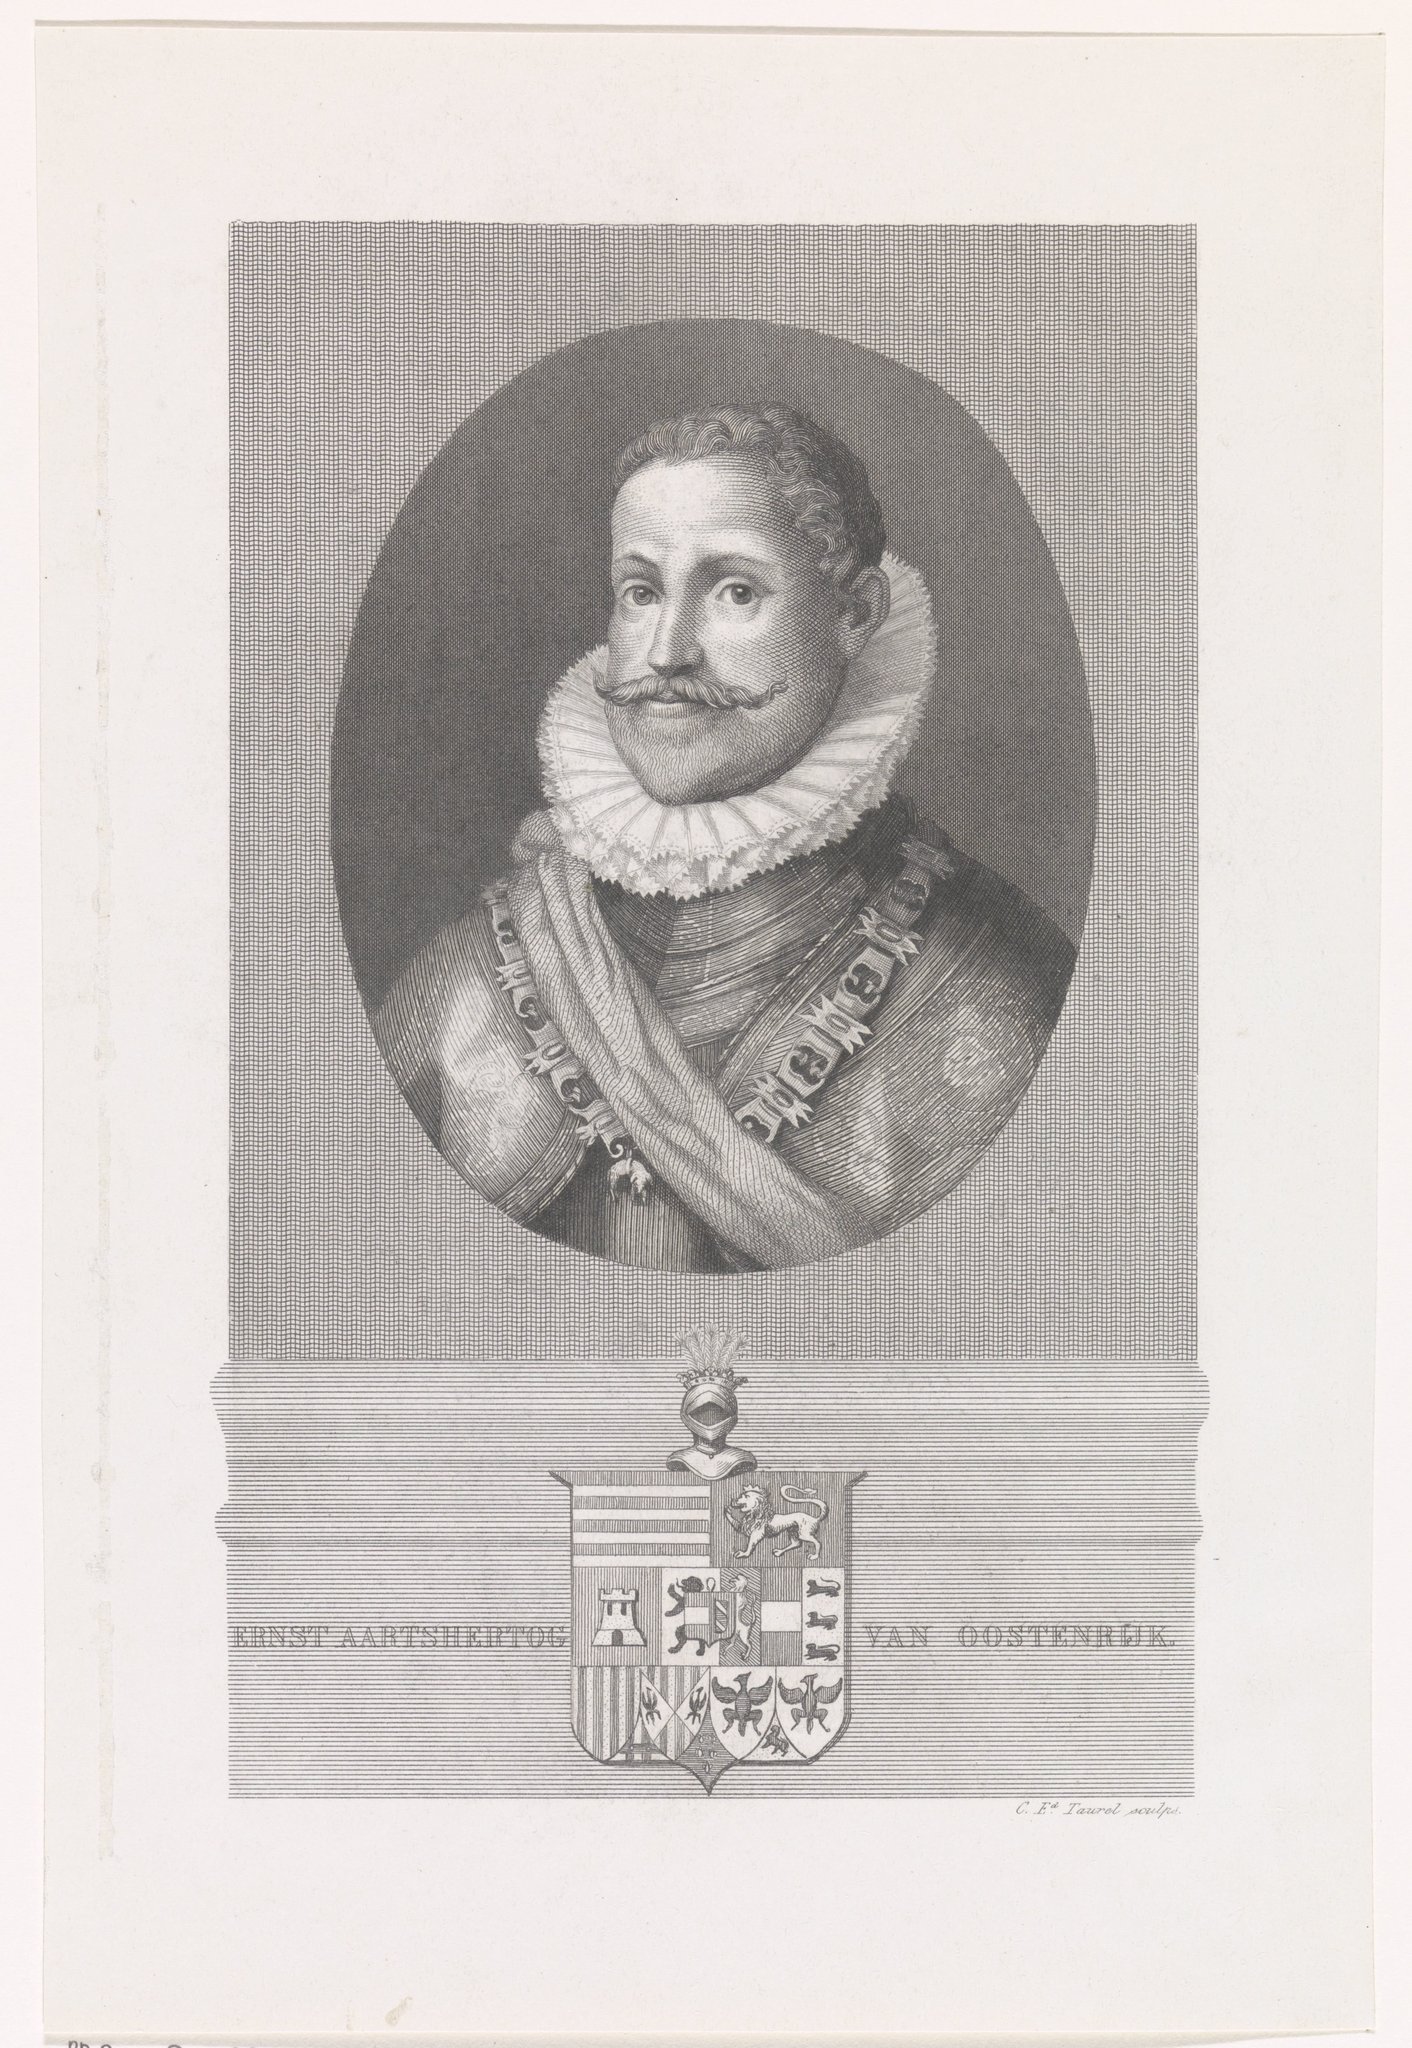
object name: print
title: Portret van Ernst, aartshertog van Oostenrijk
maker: edouard taurel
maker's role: draughtsman, print maker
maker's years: 1824-1892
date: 1841-1879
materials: paper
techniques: engraving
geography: amsterdam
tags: vienna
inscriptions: collector's mark: Lugt 2228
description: Prent ook gebruikt als illustratie voor: Arend, Johannes Pieter. Algemeene geschiedenis des vaderlands van de vroegste tijden tot op heden. 5 delen. Amsterdam: J.F. Schleijer, 1841-1884. dl. III.1, p. 477.